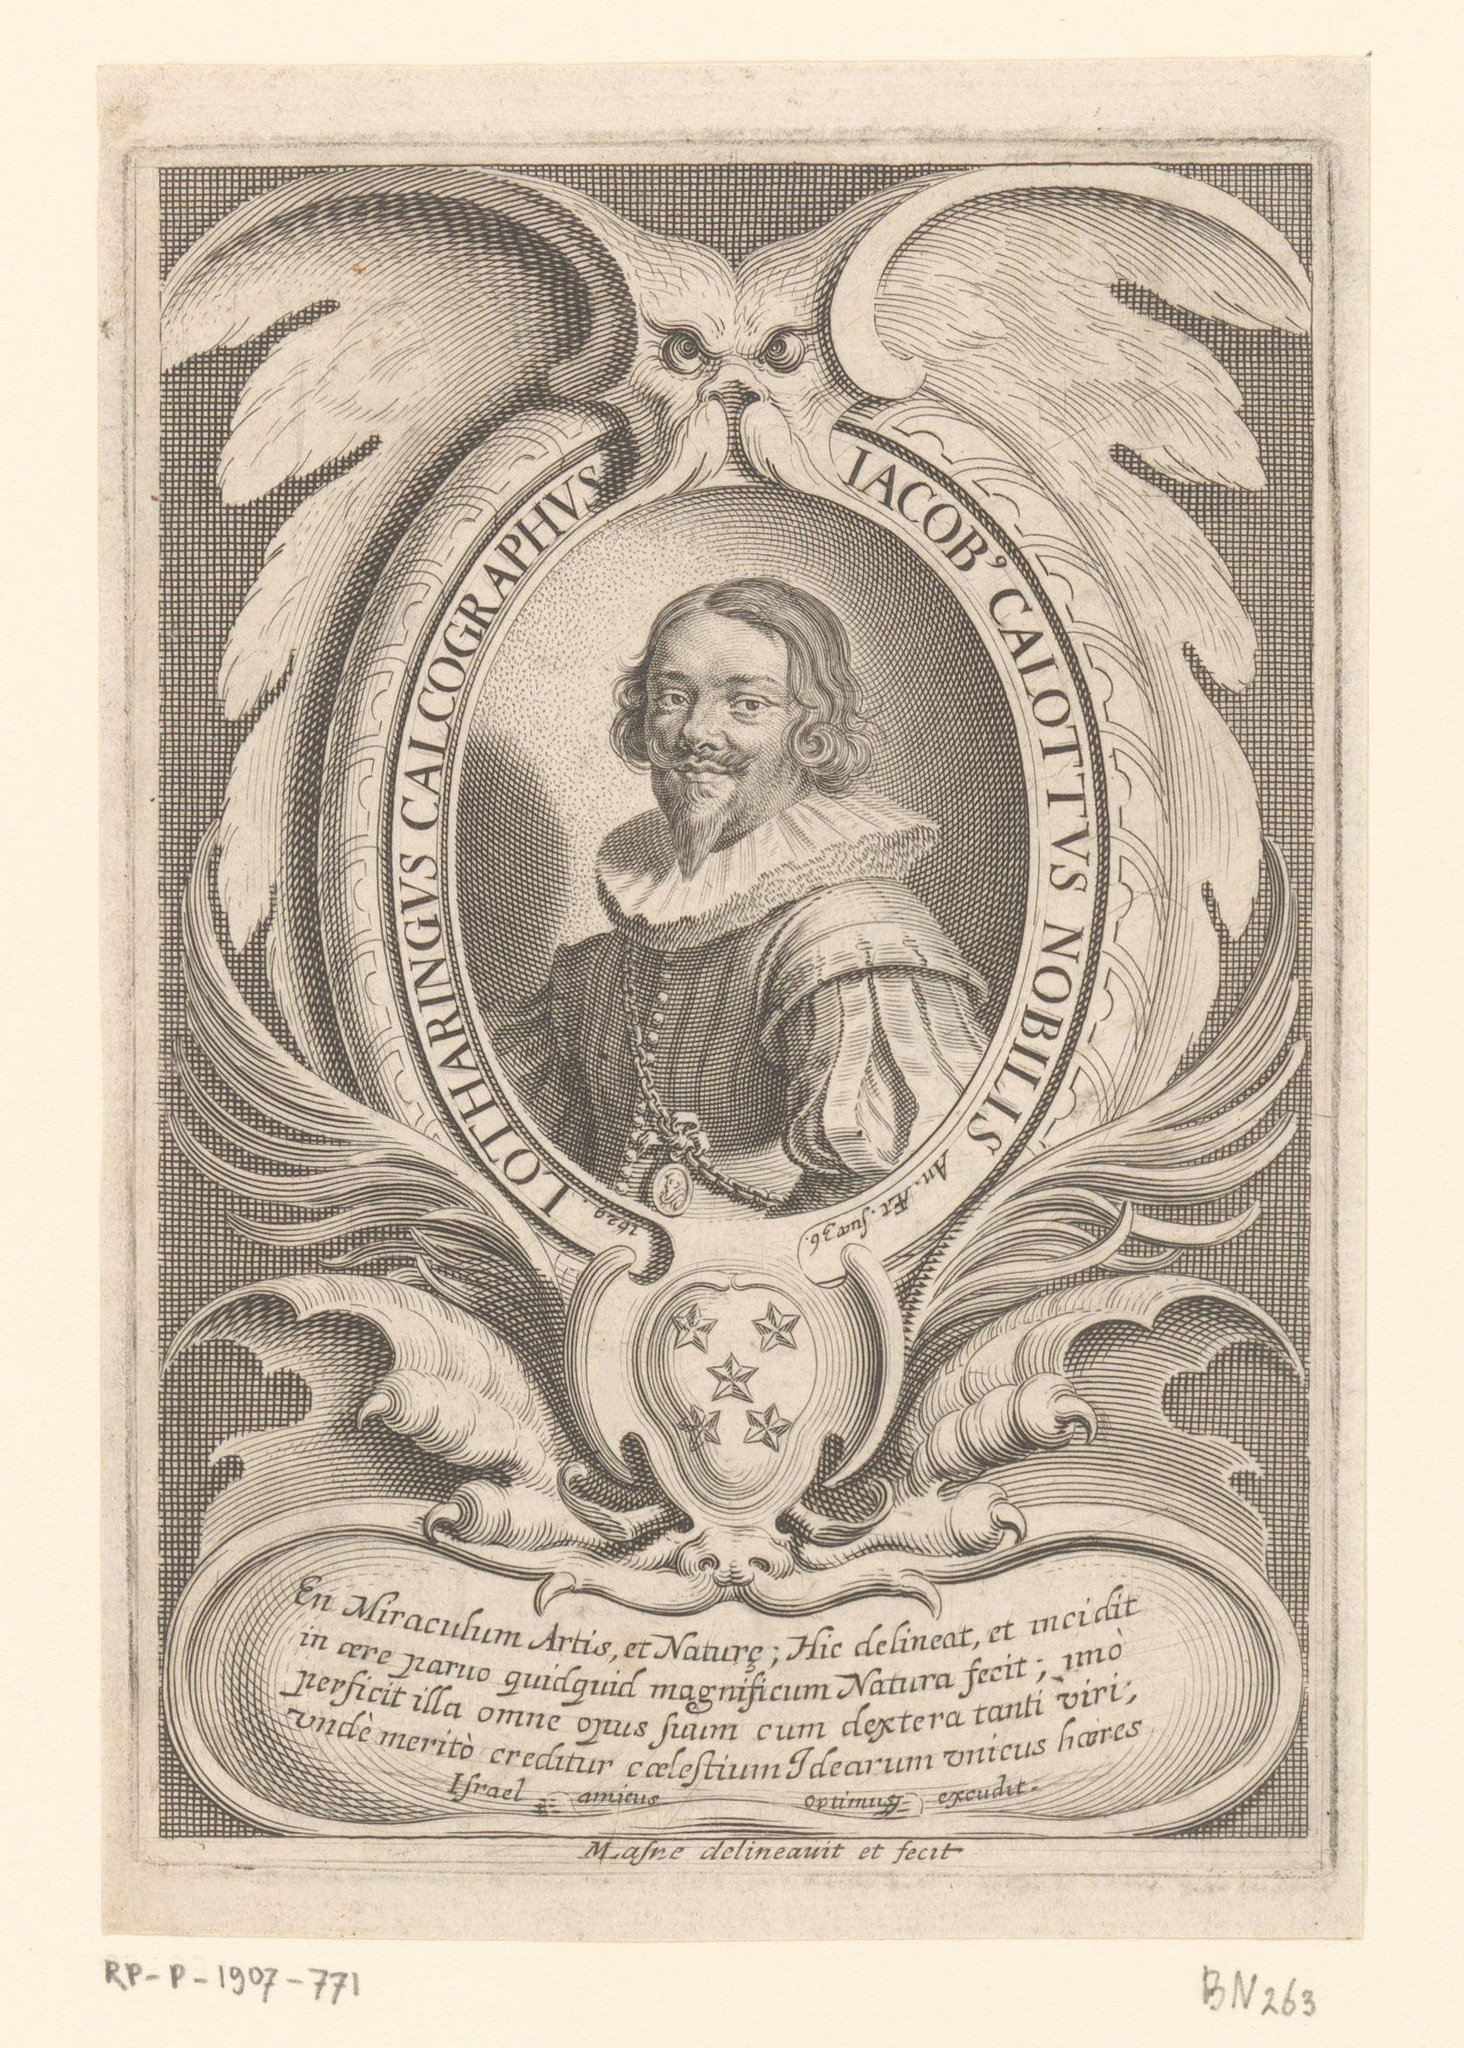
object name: print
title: Portret van Jacques Callot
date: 1629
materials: paper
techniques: engraving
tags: print maker, draughtsman, jacques callot, auricular ornament, lobe style ~ ornament, historical persons, portrait, self-portrait of artist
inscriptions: collector's mark: Lugt 2228